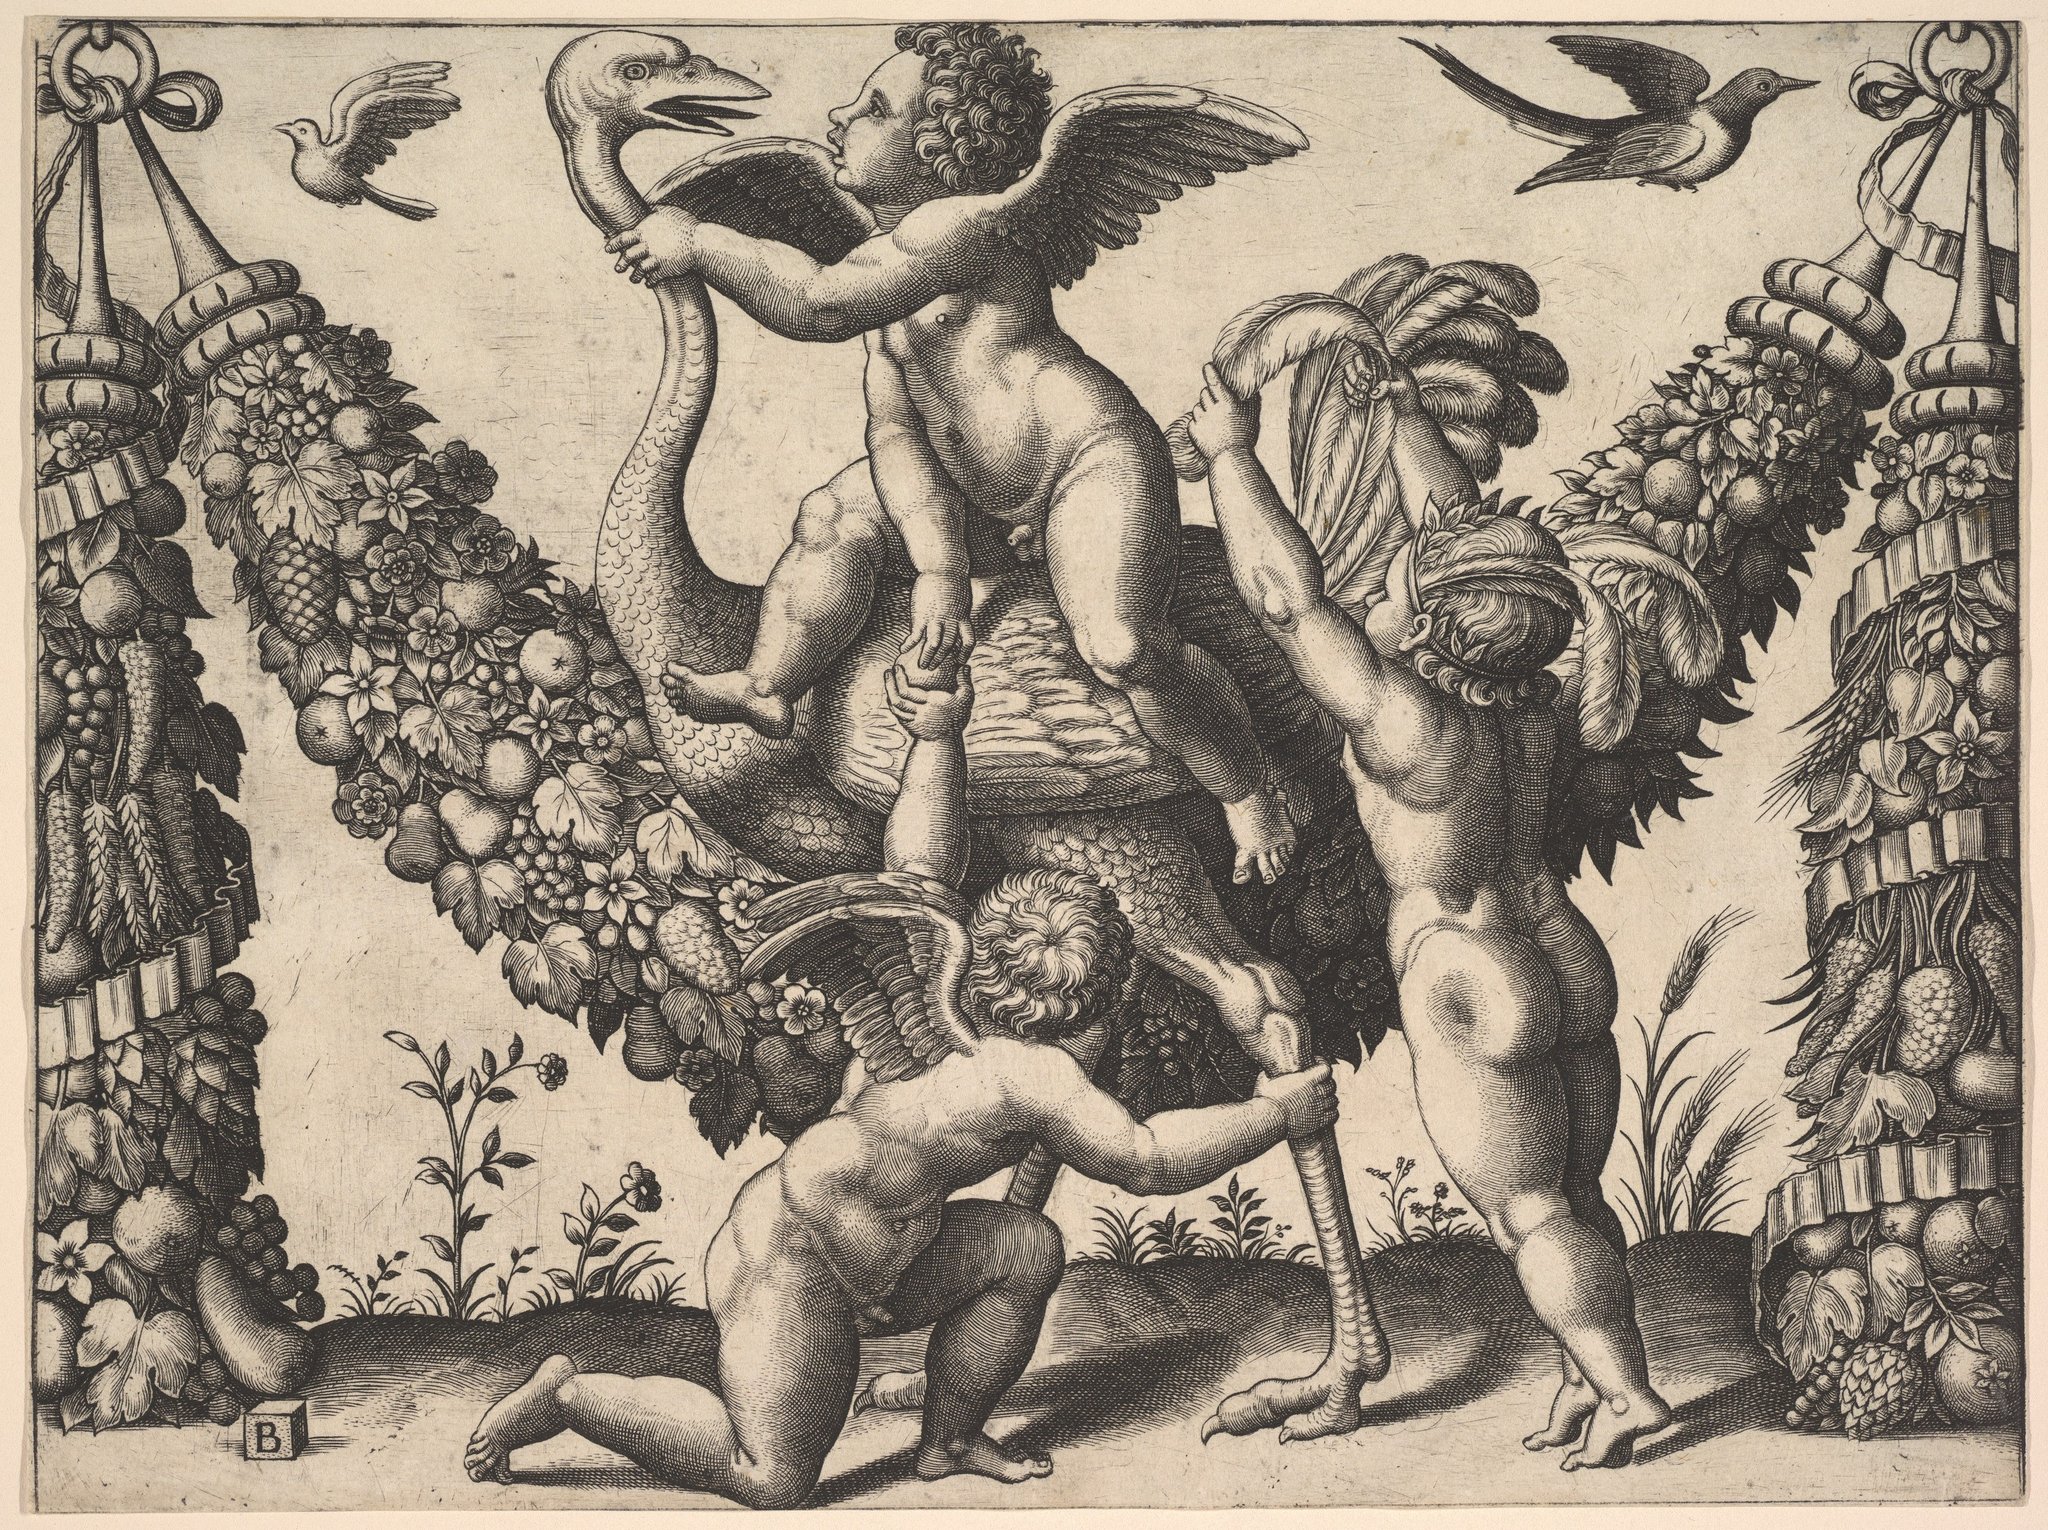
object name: print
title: Three putti before a large garland, the one in the middle rides an ostrich, from a series of tapestries made for Leo X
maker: master of the die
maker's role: artist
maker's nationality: italian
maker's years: 1525-1560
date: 1530-1540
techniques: engraving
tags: birds,garlands,putti